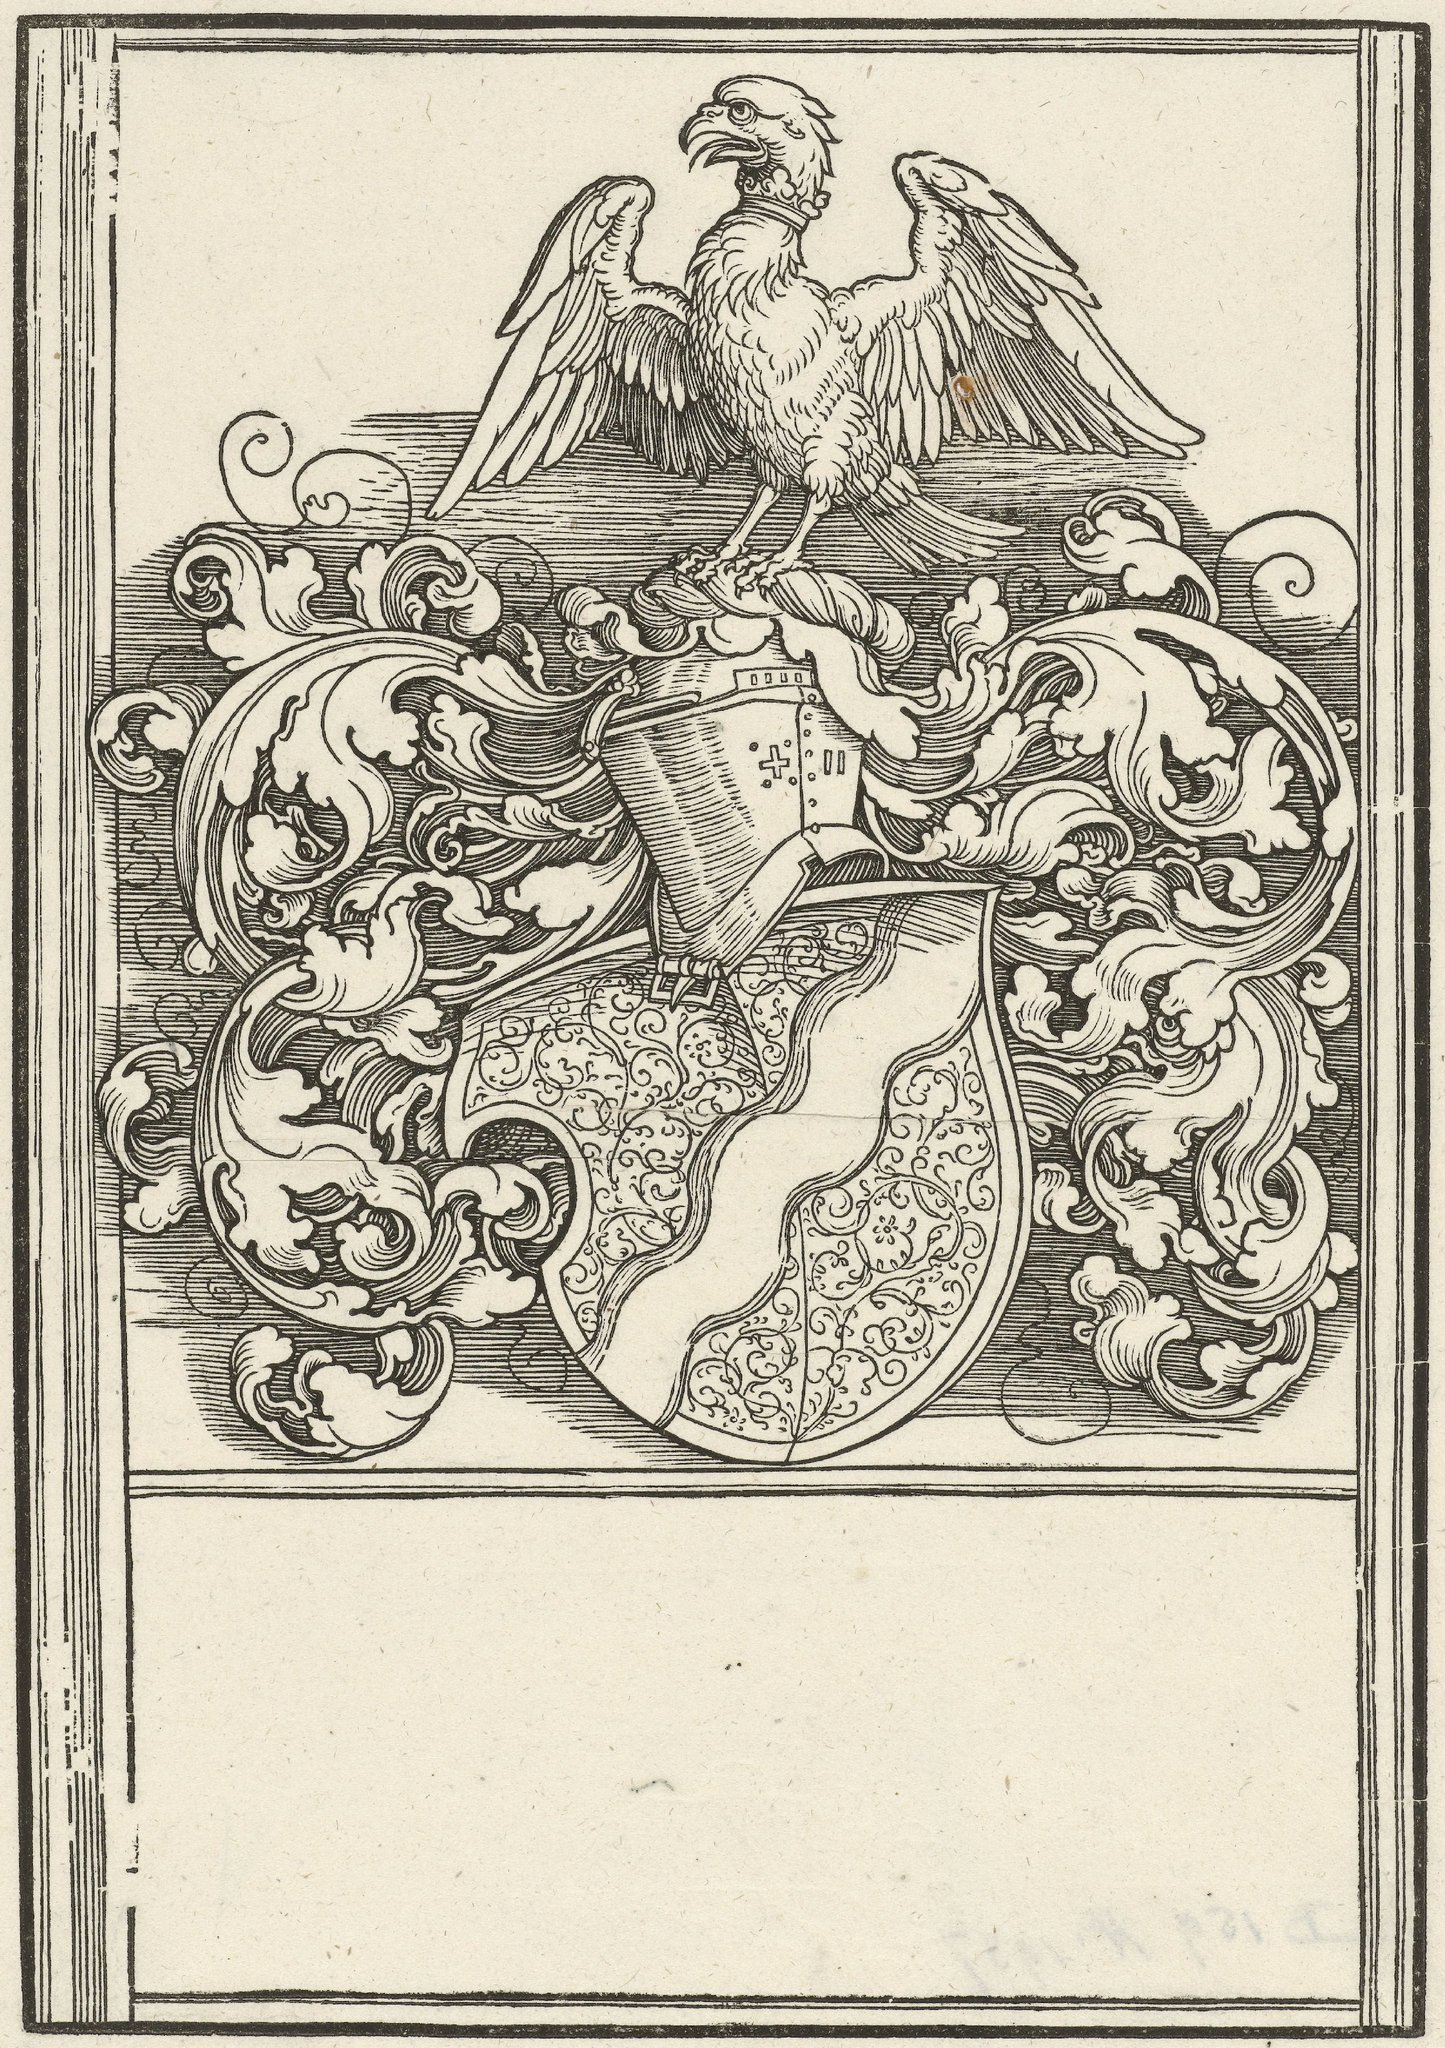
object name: print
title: Wapen van Michael Behaim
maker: albrecht dürer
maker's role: draughtsman, painter, print maker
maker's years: 1471-1528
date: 1518-1520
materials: paper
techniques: woodcut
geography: nuremberg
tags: armorial bearing, heraldry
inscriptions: collector's mark: Lugt 240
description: Het wapenschild van de Neurenbergse familie Behaim von Schwarzbach, bekroond door een helm, waarop een adelaar staat. Het geheel omgeven door bladmotieven. Onder de voorstelling een rechthoekig leeg vlak.